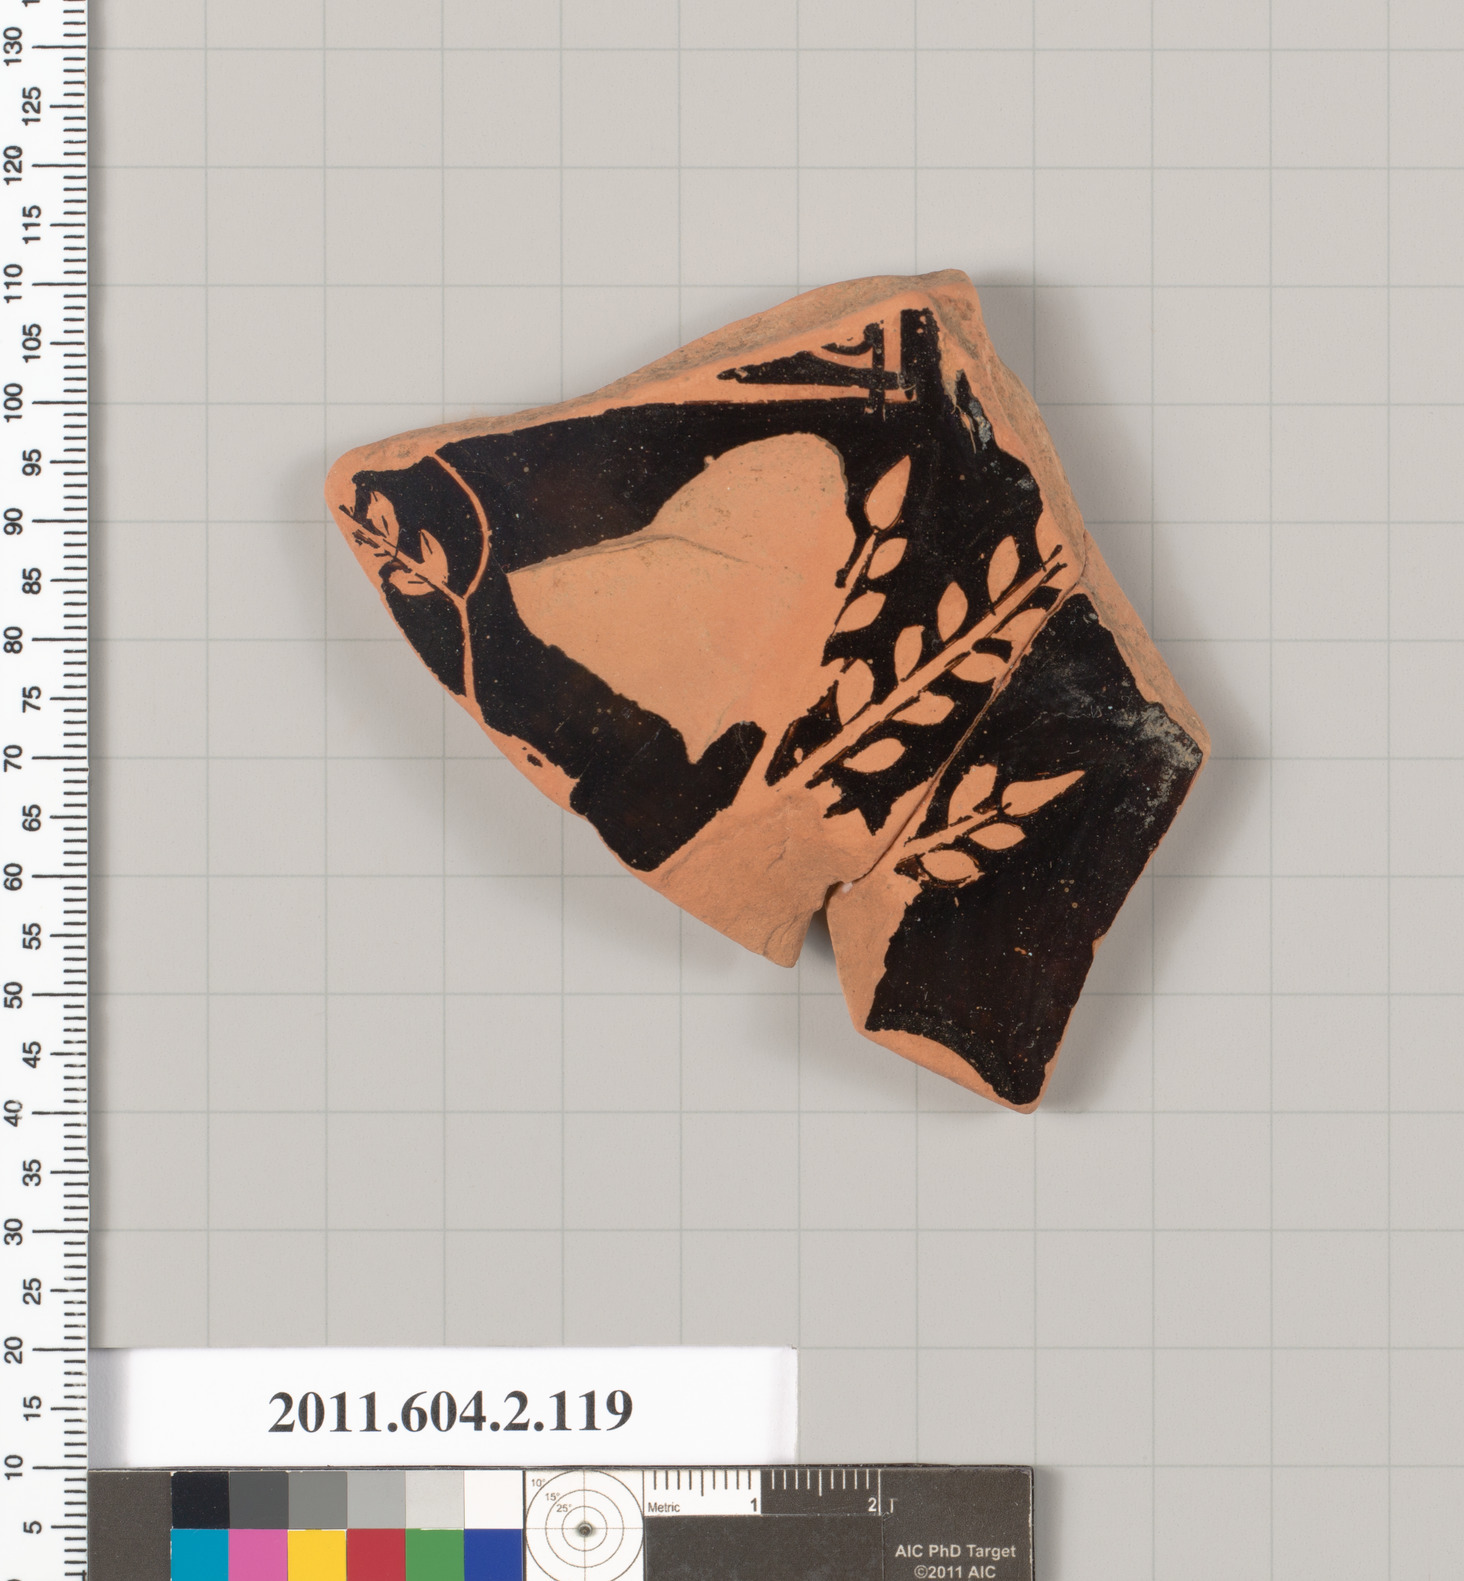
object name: pelike fragment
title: Terracotta fragment of a pelike (jar)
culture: greek, attic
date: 475-451 BCE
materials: terracotta